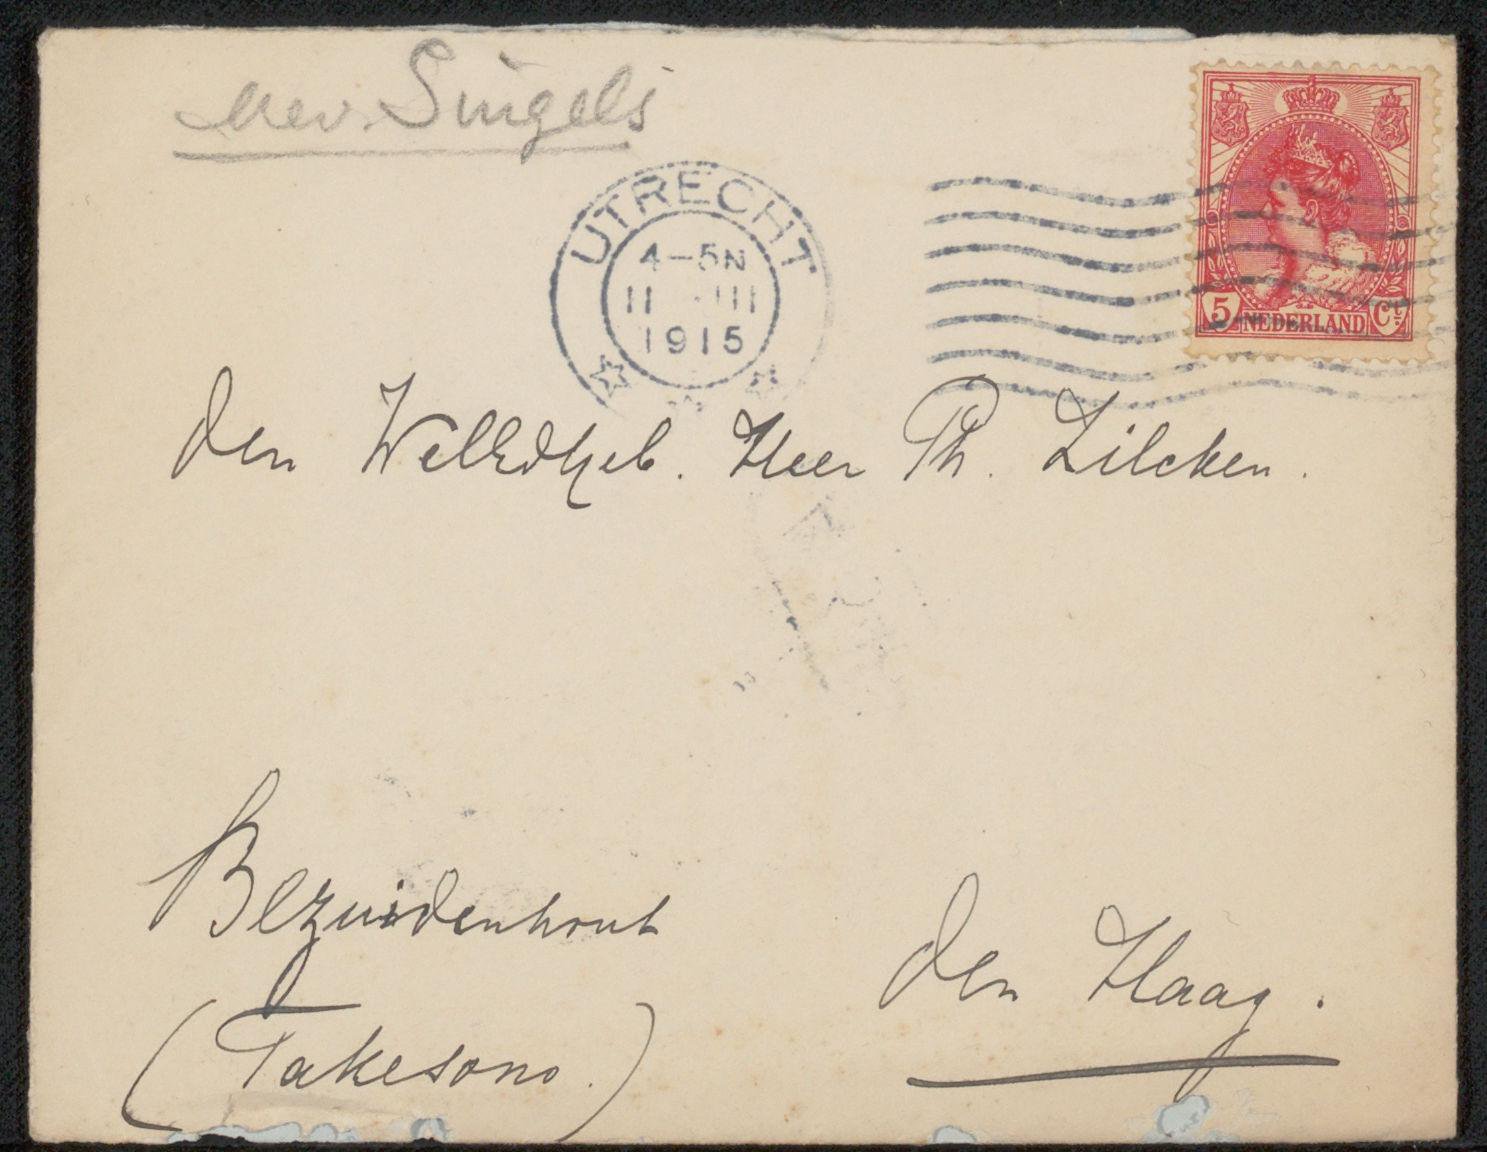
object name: envelope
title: Envelop aan Philip Zilcken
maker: anna singels-heintz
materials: ink, paper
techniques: pen, writing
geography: utrecht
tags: the hague, painter, draughtsman, philip zilcken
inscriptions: collector's mark: ‘RPK’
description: Vermoedelijk is brief RP-D-1982-43-SINGELS-24 in deze envelop verstuurd.